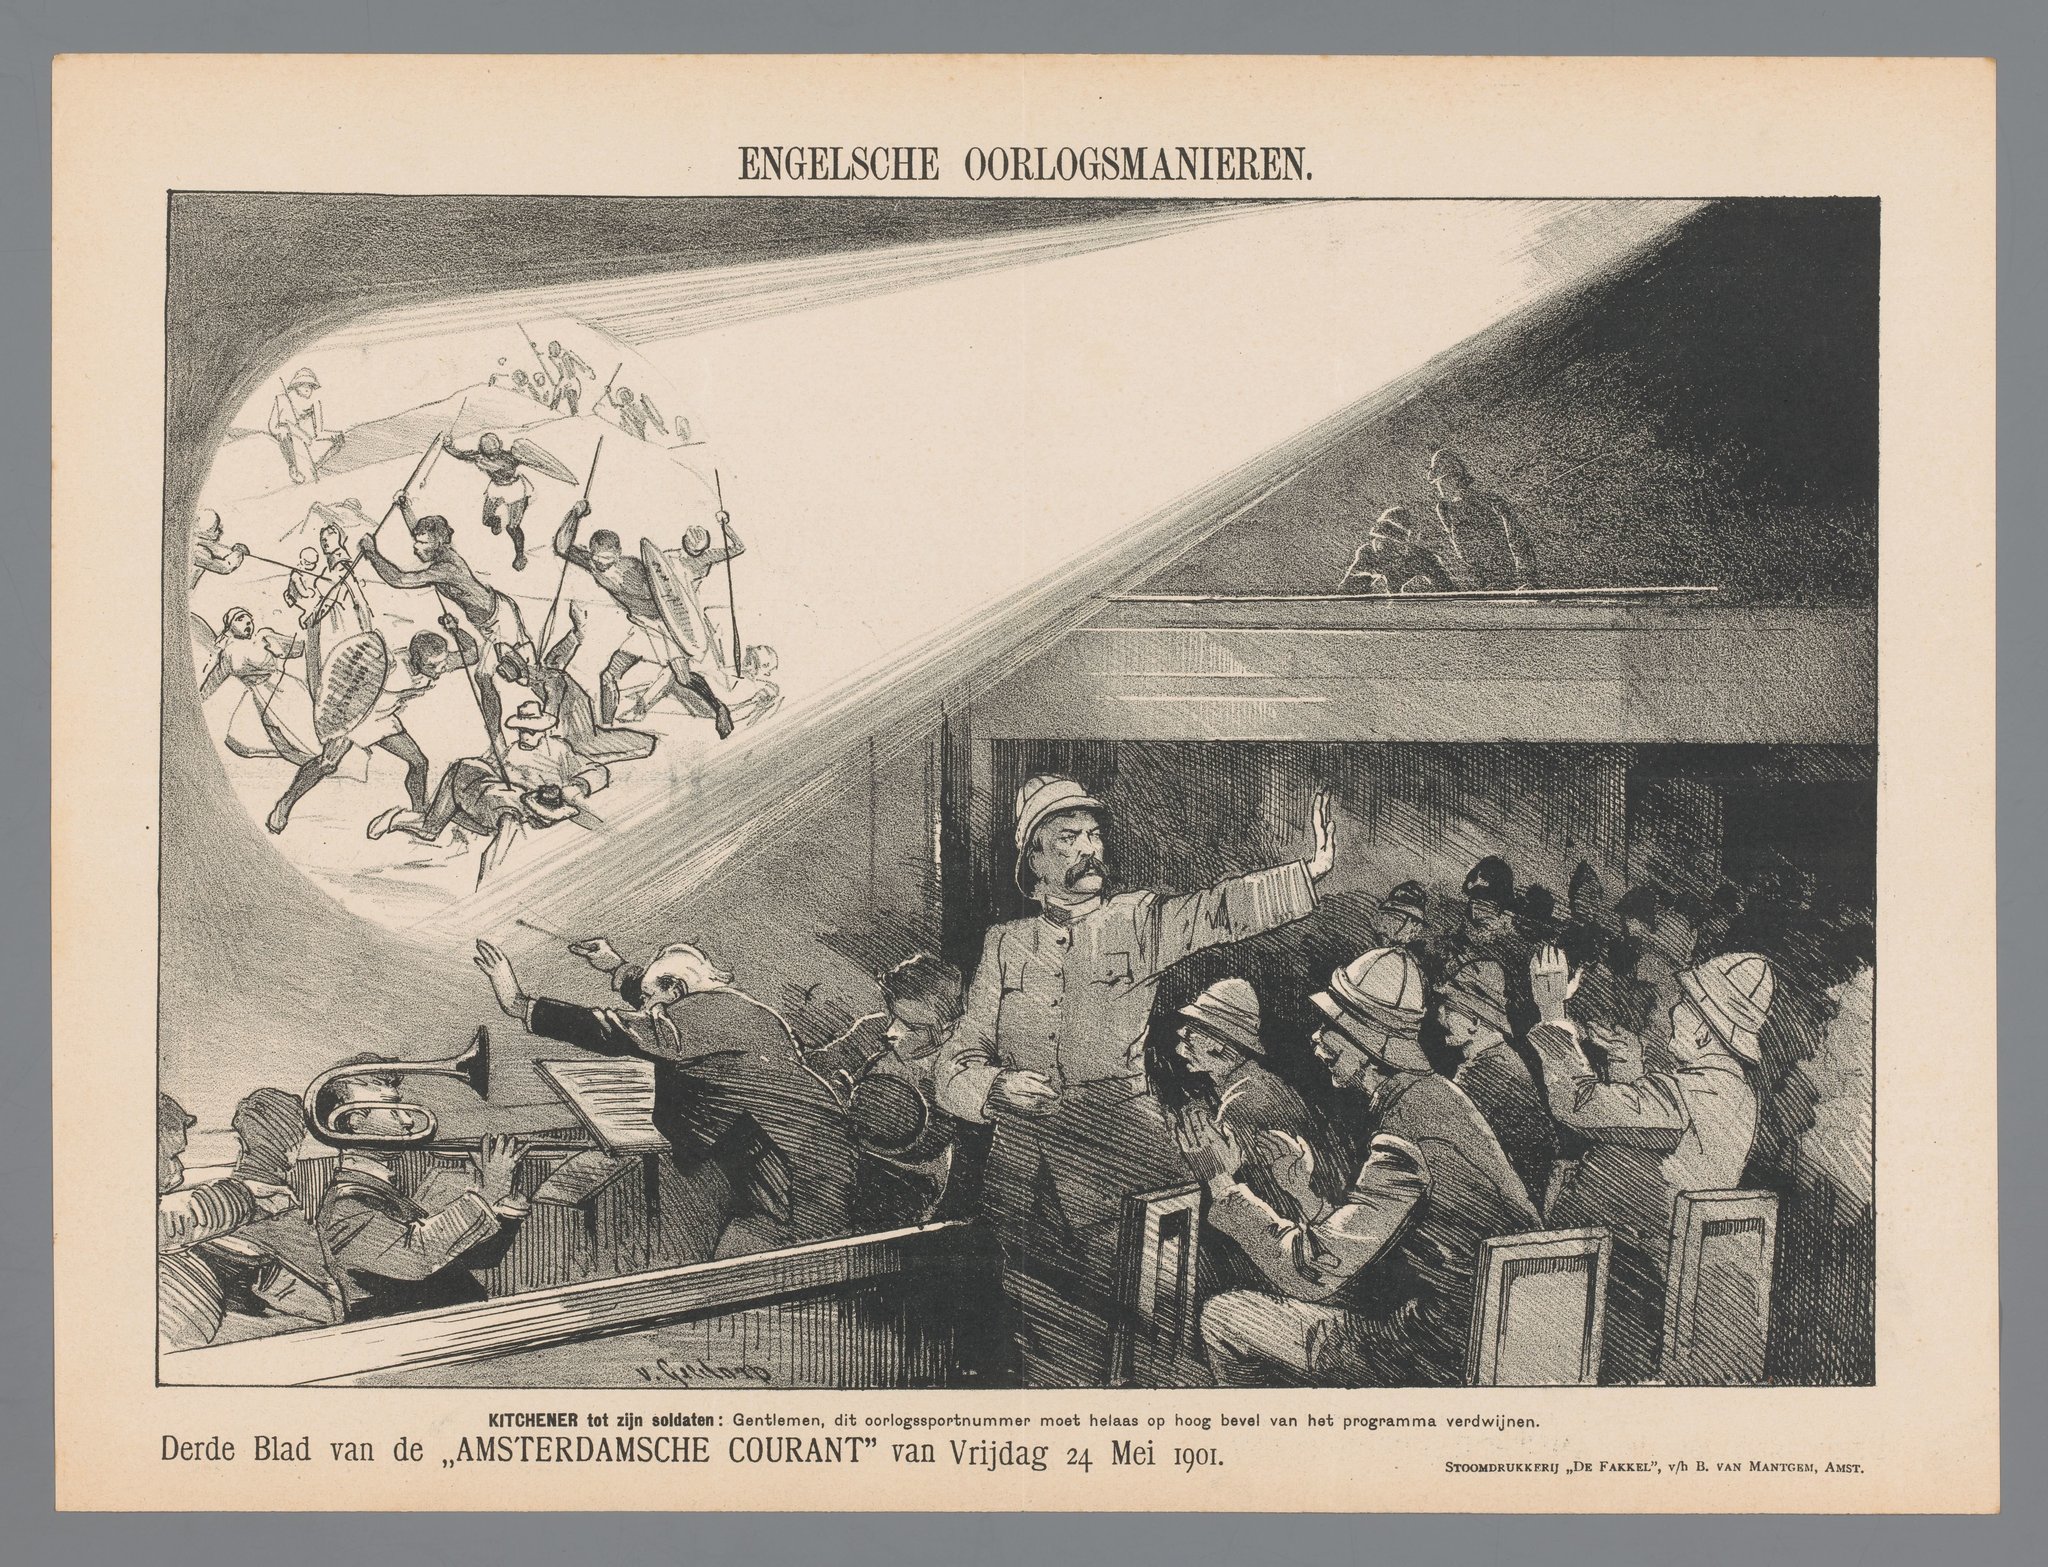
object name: cartoon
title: Engelsche oorlogsmanieren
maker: petrus van geldorp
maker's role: draughtsman, print maker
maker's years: 1872-1939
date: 1901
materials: paper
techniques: lithograph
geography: amsterdam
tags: horatio herbert kitchener, cinema, movie-house, historical persons, war, political caricatures and satires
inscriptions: date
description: Prent uit het bijvoegsel van: De Amsterdamsche Courant, 24 mei 1901.